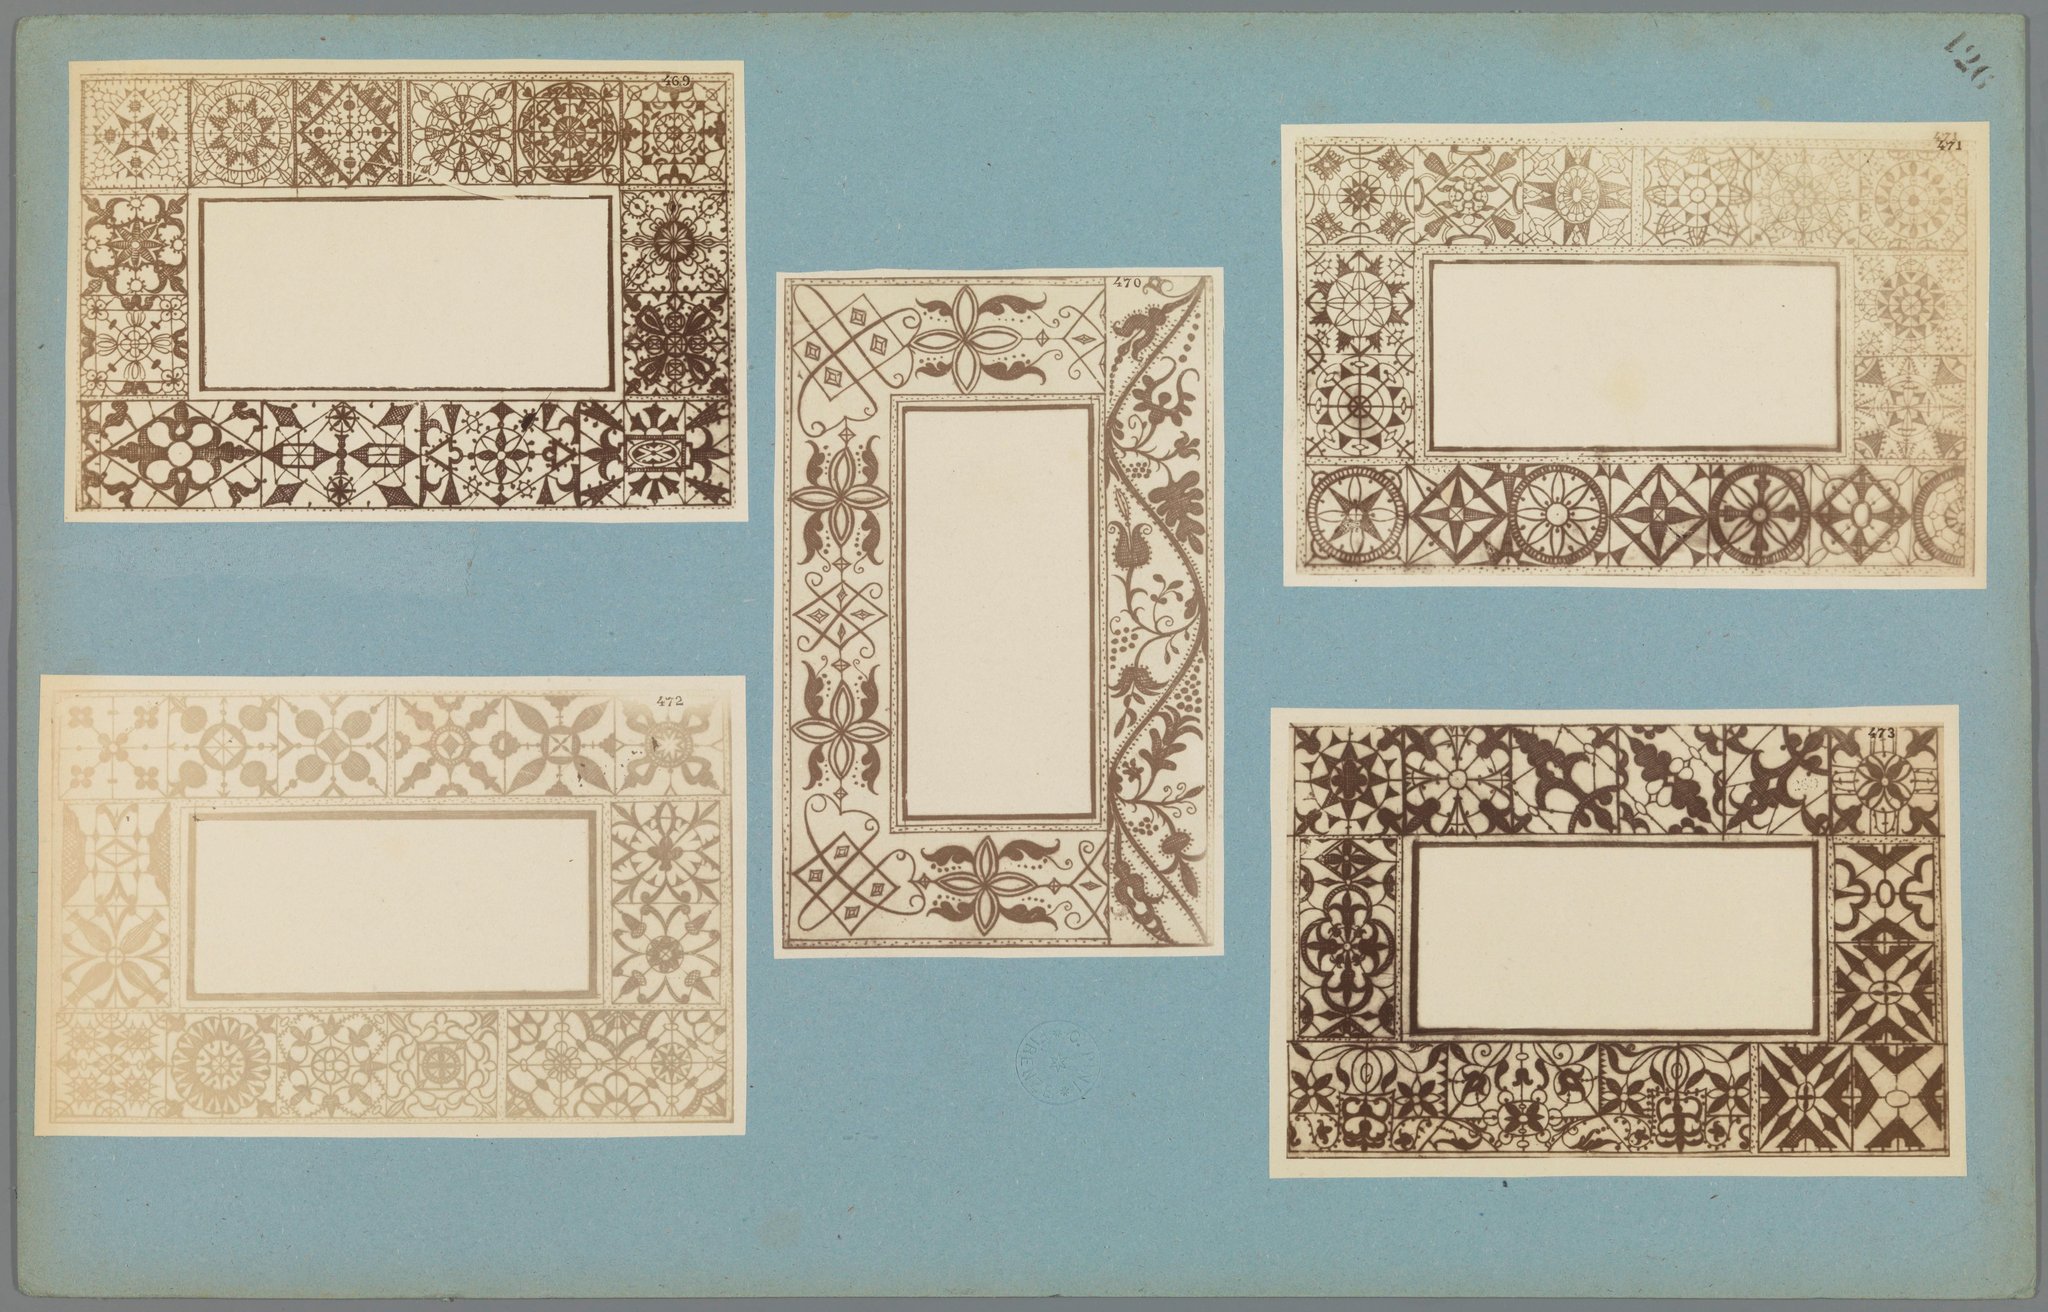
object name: photograph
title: Vijf fotoreproducties van ornamentprenten met abstracte patronen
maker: Anonymous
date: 1875-1900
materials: cardboard, photographic support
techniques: albumen print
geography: europe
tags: abstract interlace, knotwork ~ ornament, ornament derived from plant forms - aa - stylized, europe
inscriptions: number: ‘469’, number: ‘470’, number: ‘472’, number: ‘126’, name: ‘C. PINI FIRENZE’, number: ‘473’, number: ‘471’, collector's mark: Lugt 3937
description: Linksboven (469) een prent van een ornamentrand, linksonder (472) een prent van een ornamentrand, midden (470) een prent van geabstraheerde plantornamenten, rechtsboven (471) een prent van een ornamentrand, rechtsonder (473) een prent van een ornamentrand.